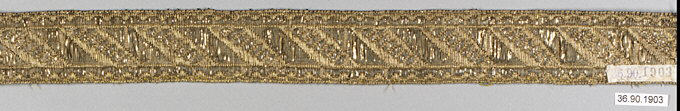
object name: galloon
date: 1767-1833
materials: metal thread, silk